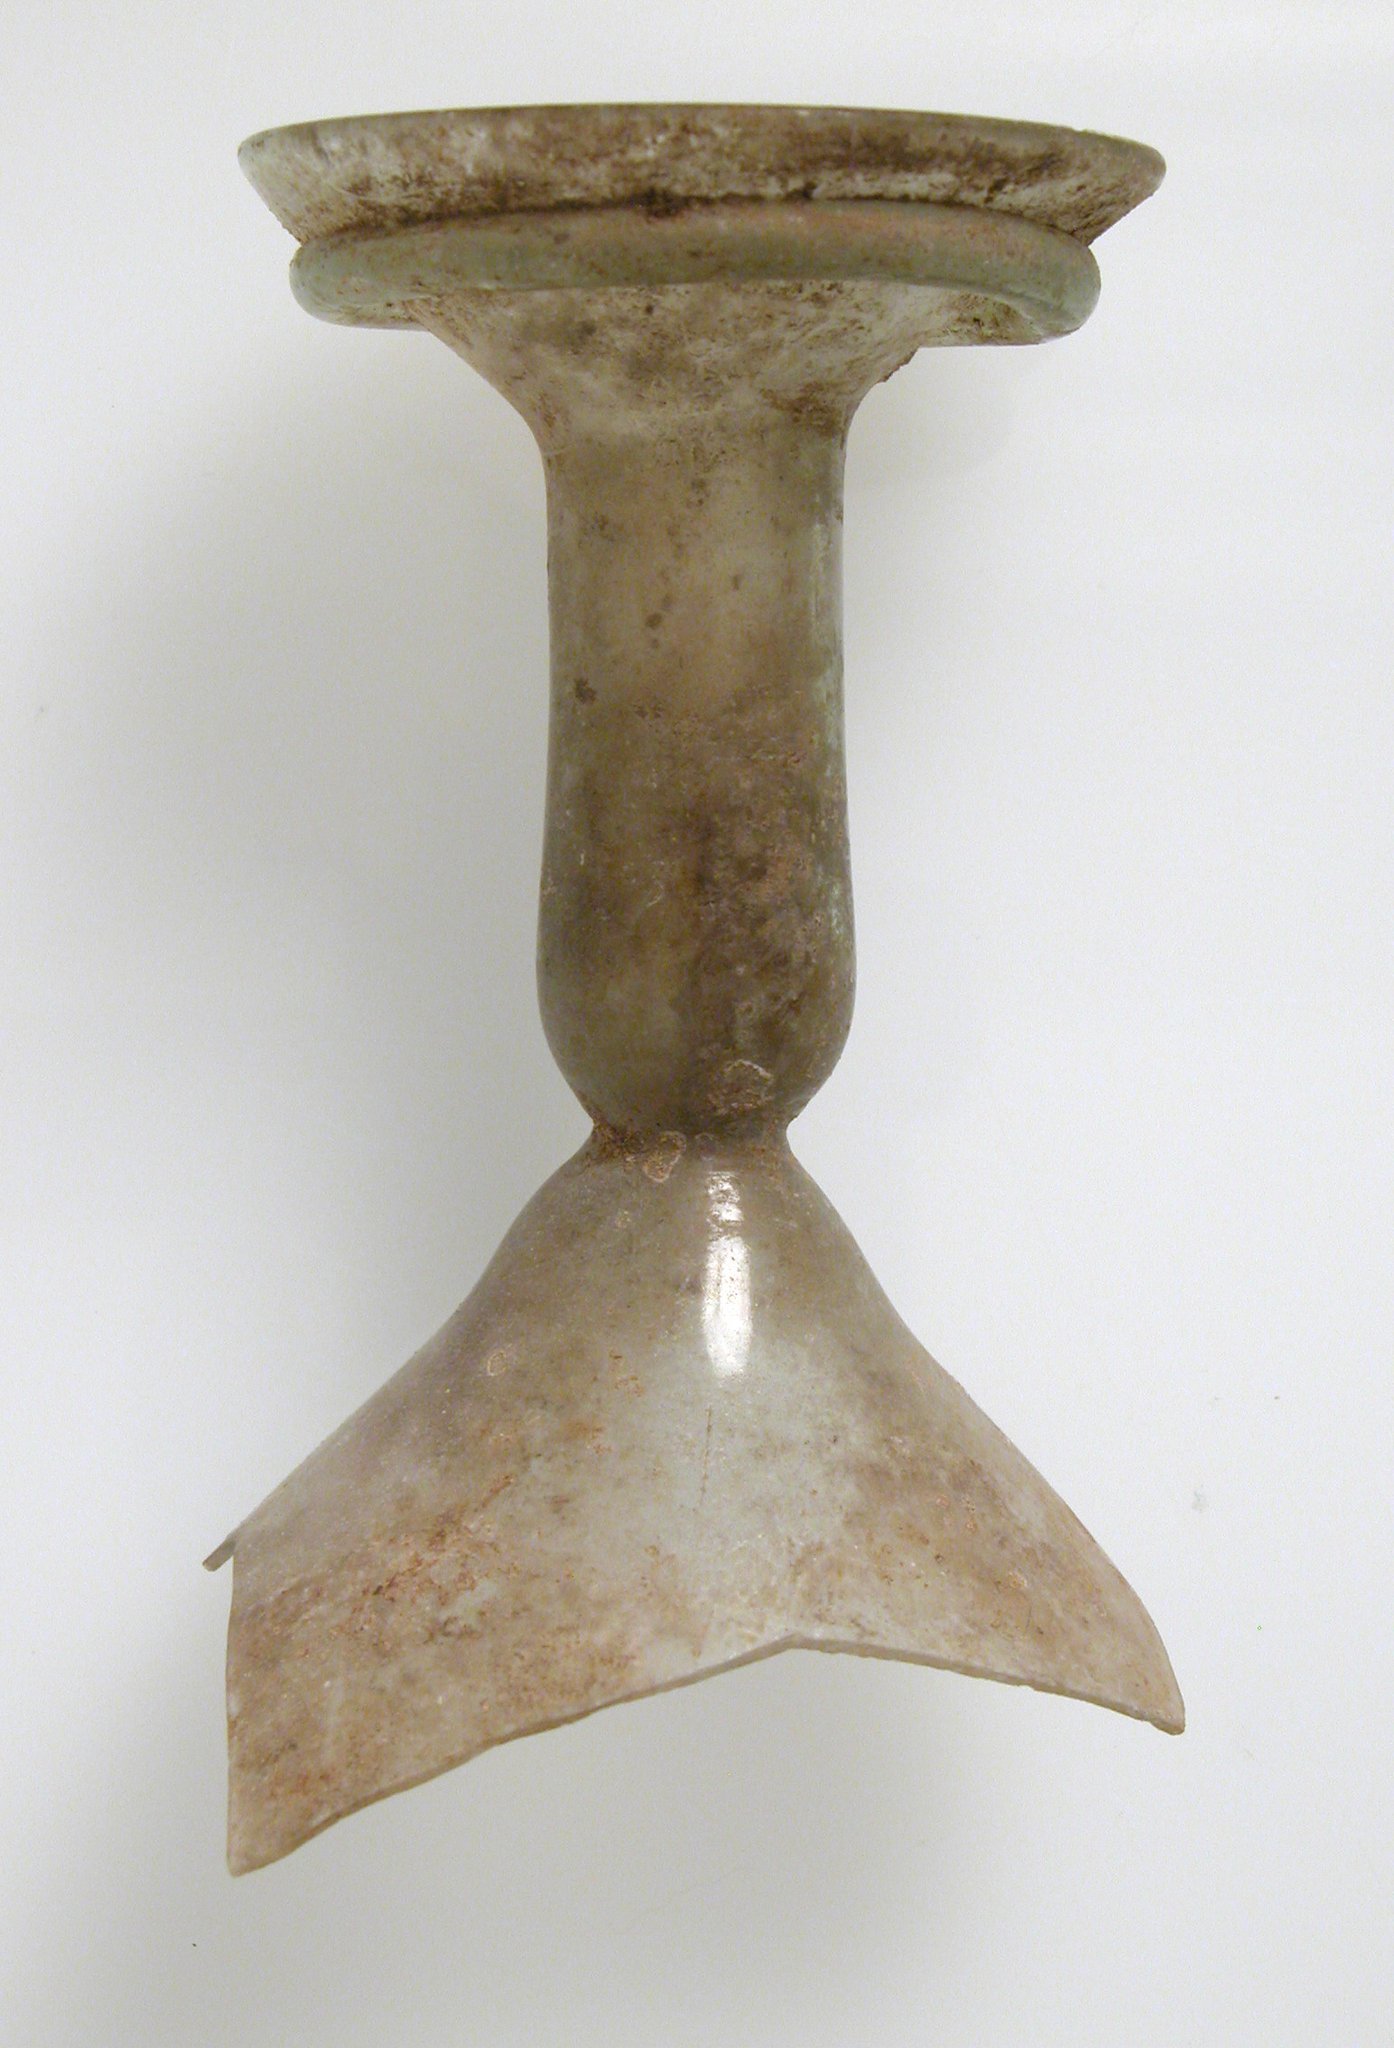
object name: fragment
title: Neck of a Bottle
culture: coptic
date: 301-433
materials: glass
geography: egypt